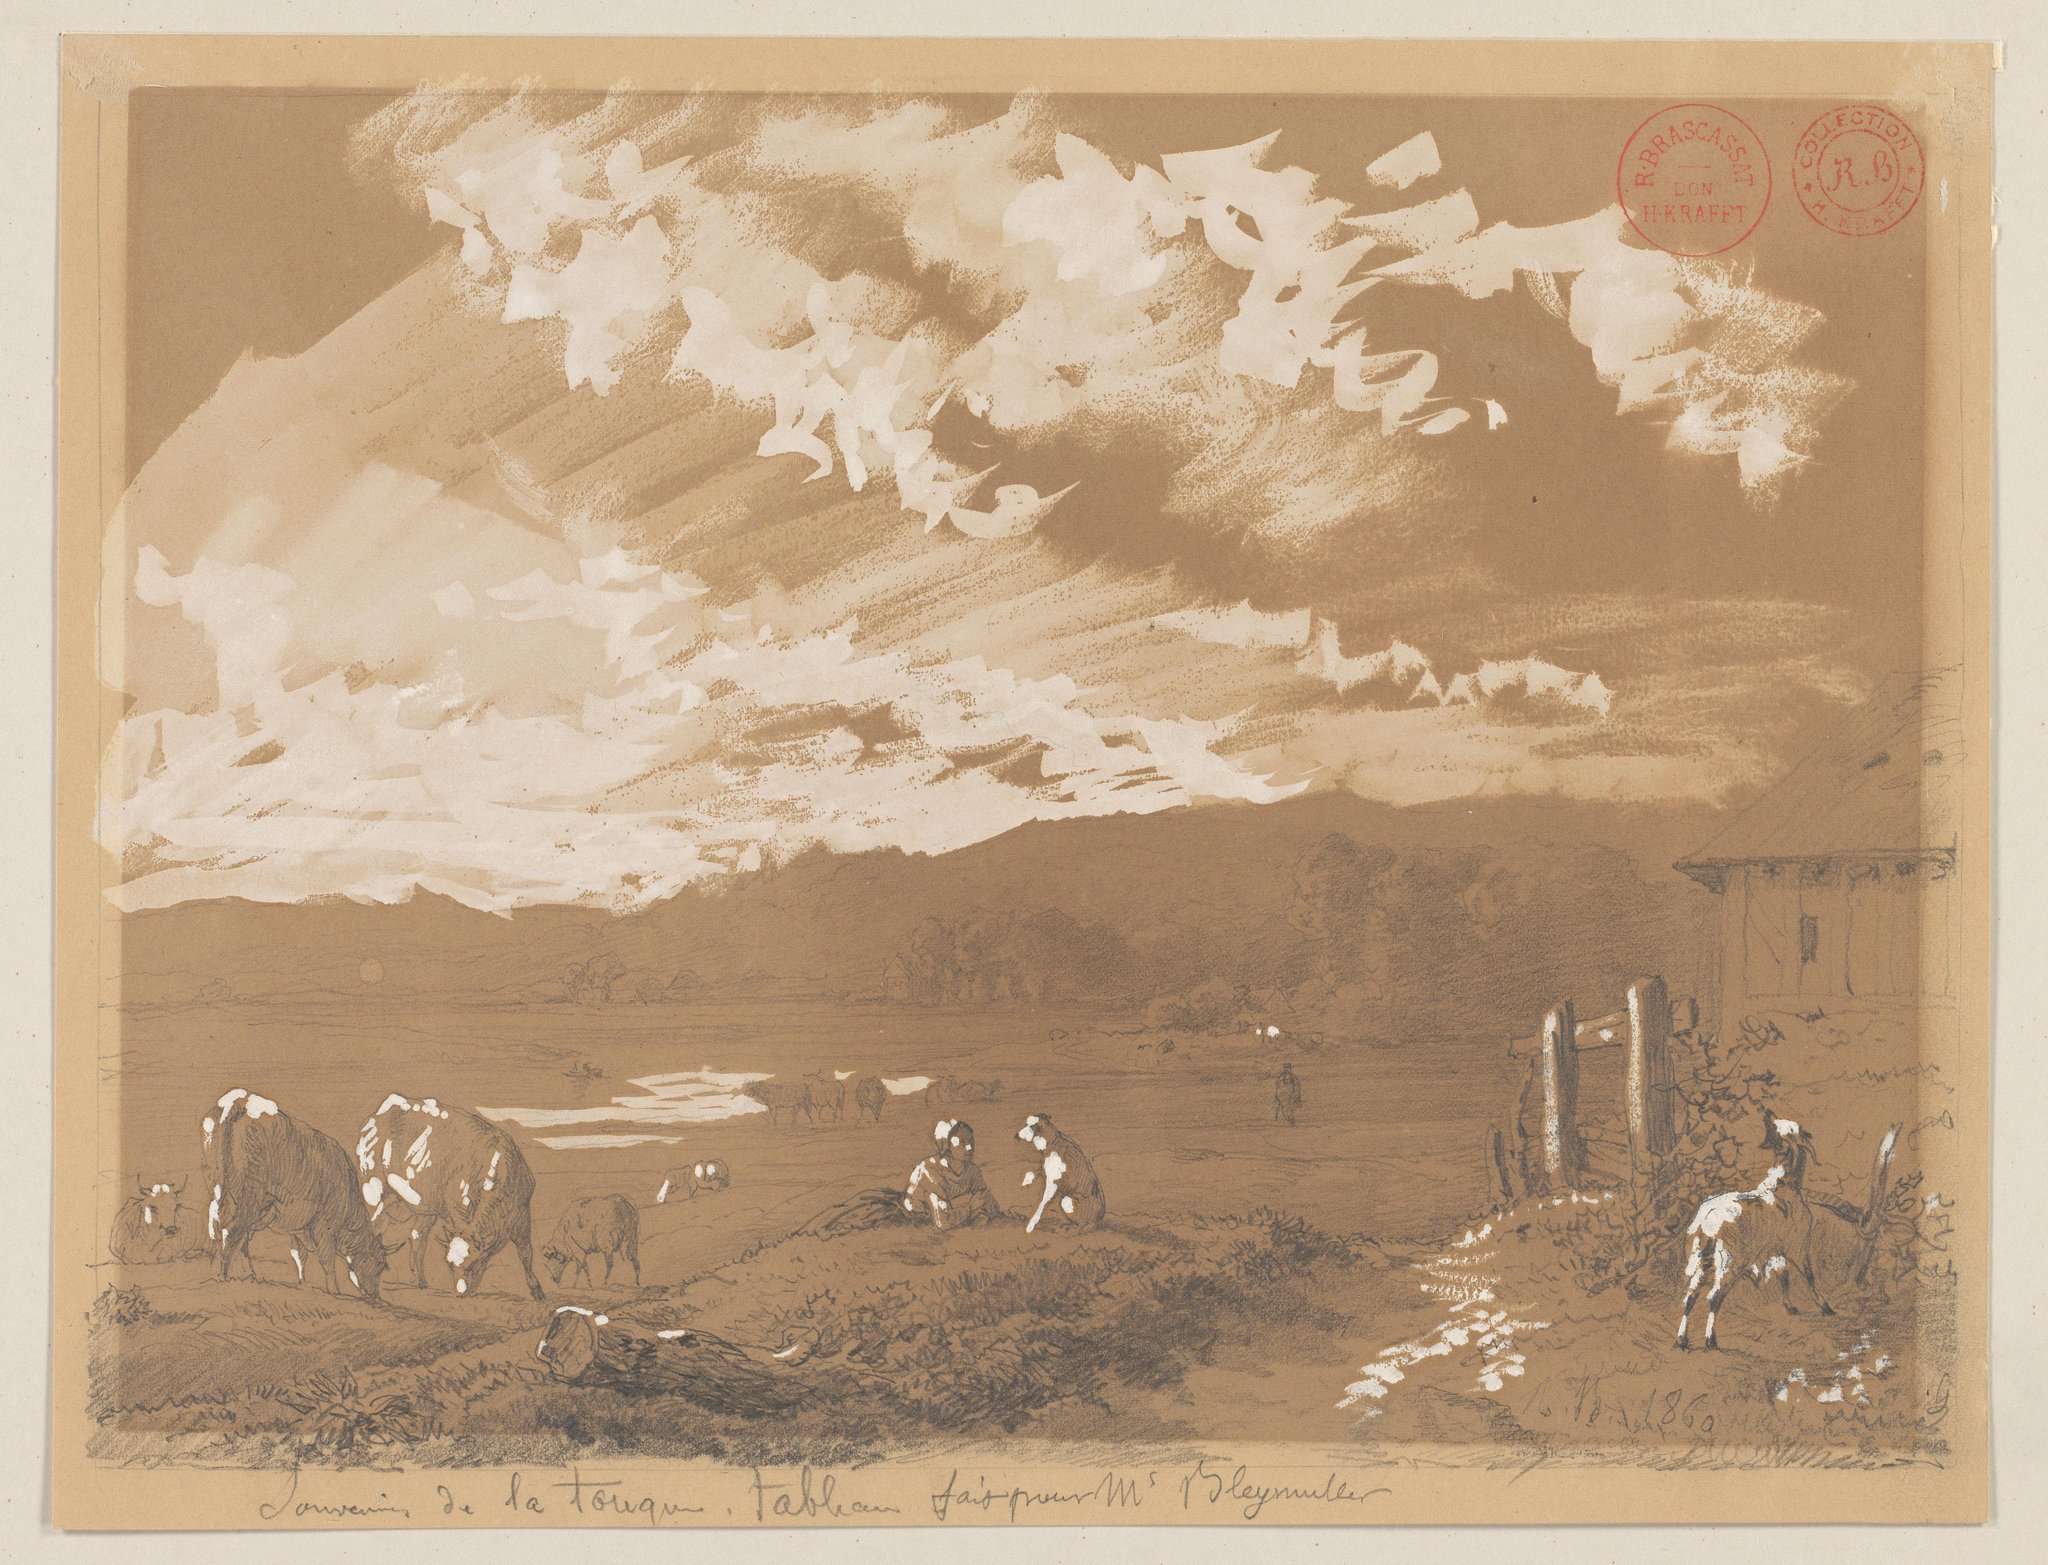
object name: drawing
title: Landschap met vrouw en hond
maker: jacques raymond brascassat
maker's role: draughtsman, print maker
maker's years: 1804-1867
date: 1860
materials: paper, pencil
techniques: brush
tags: dog